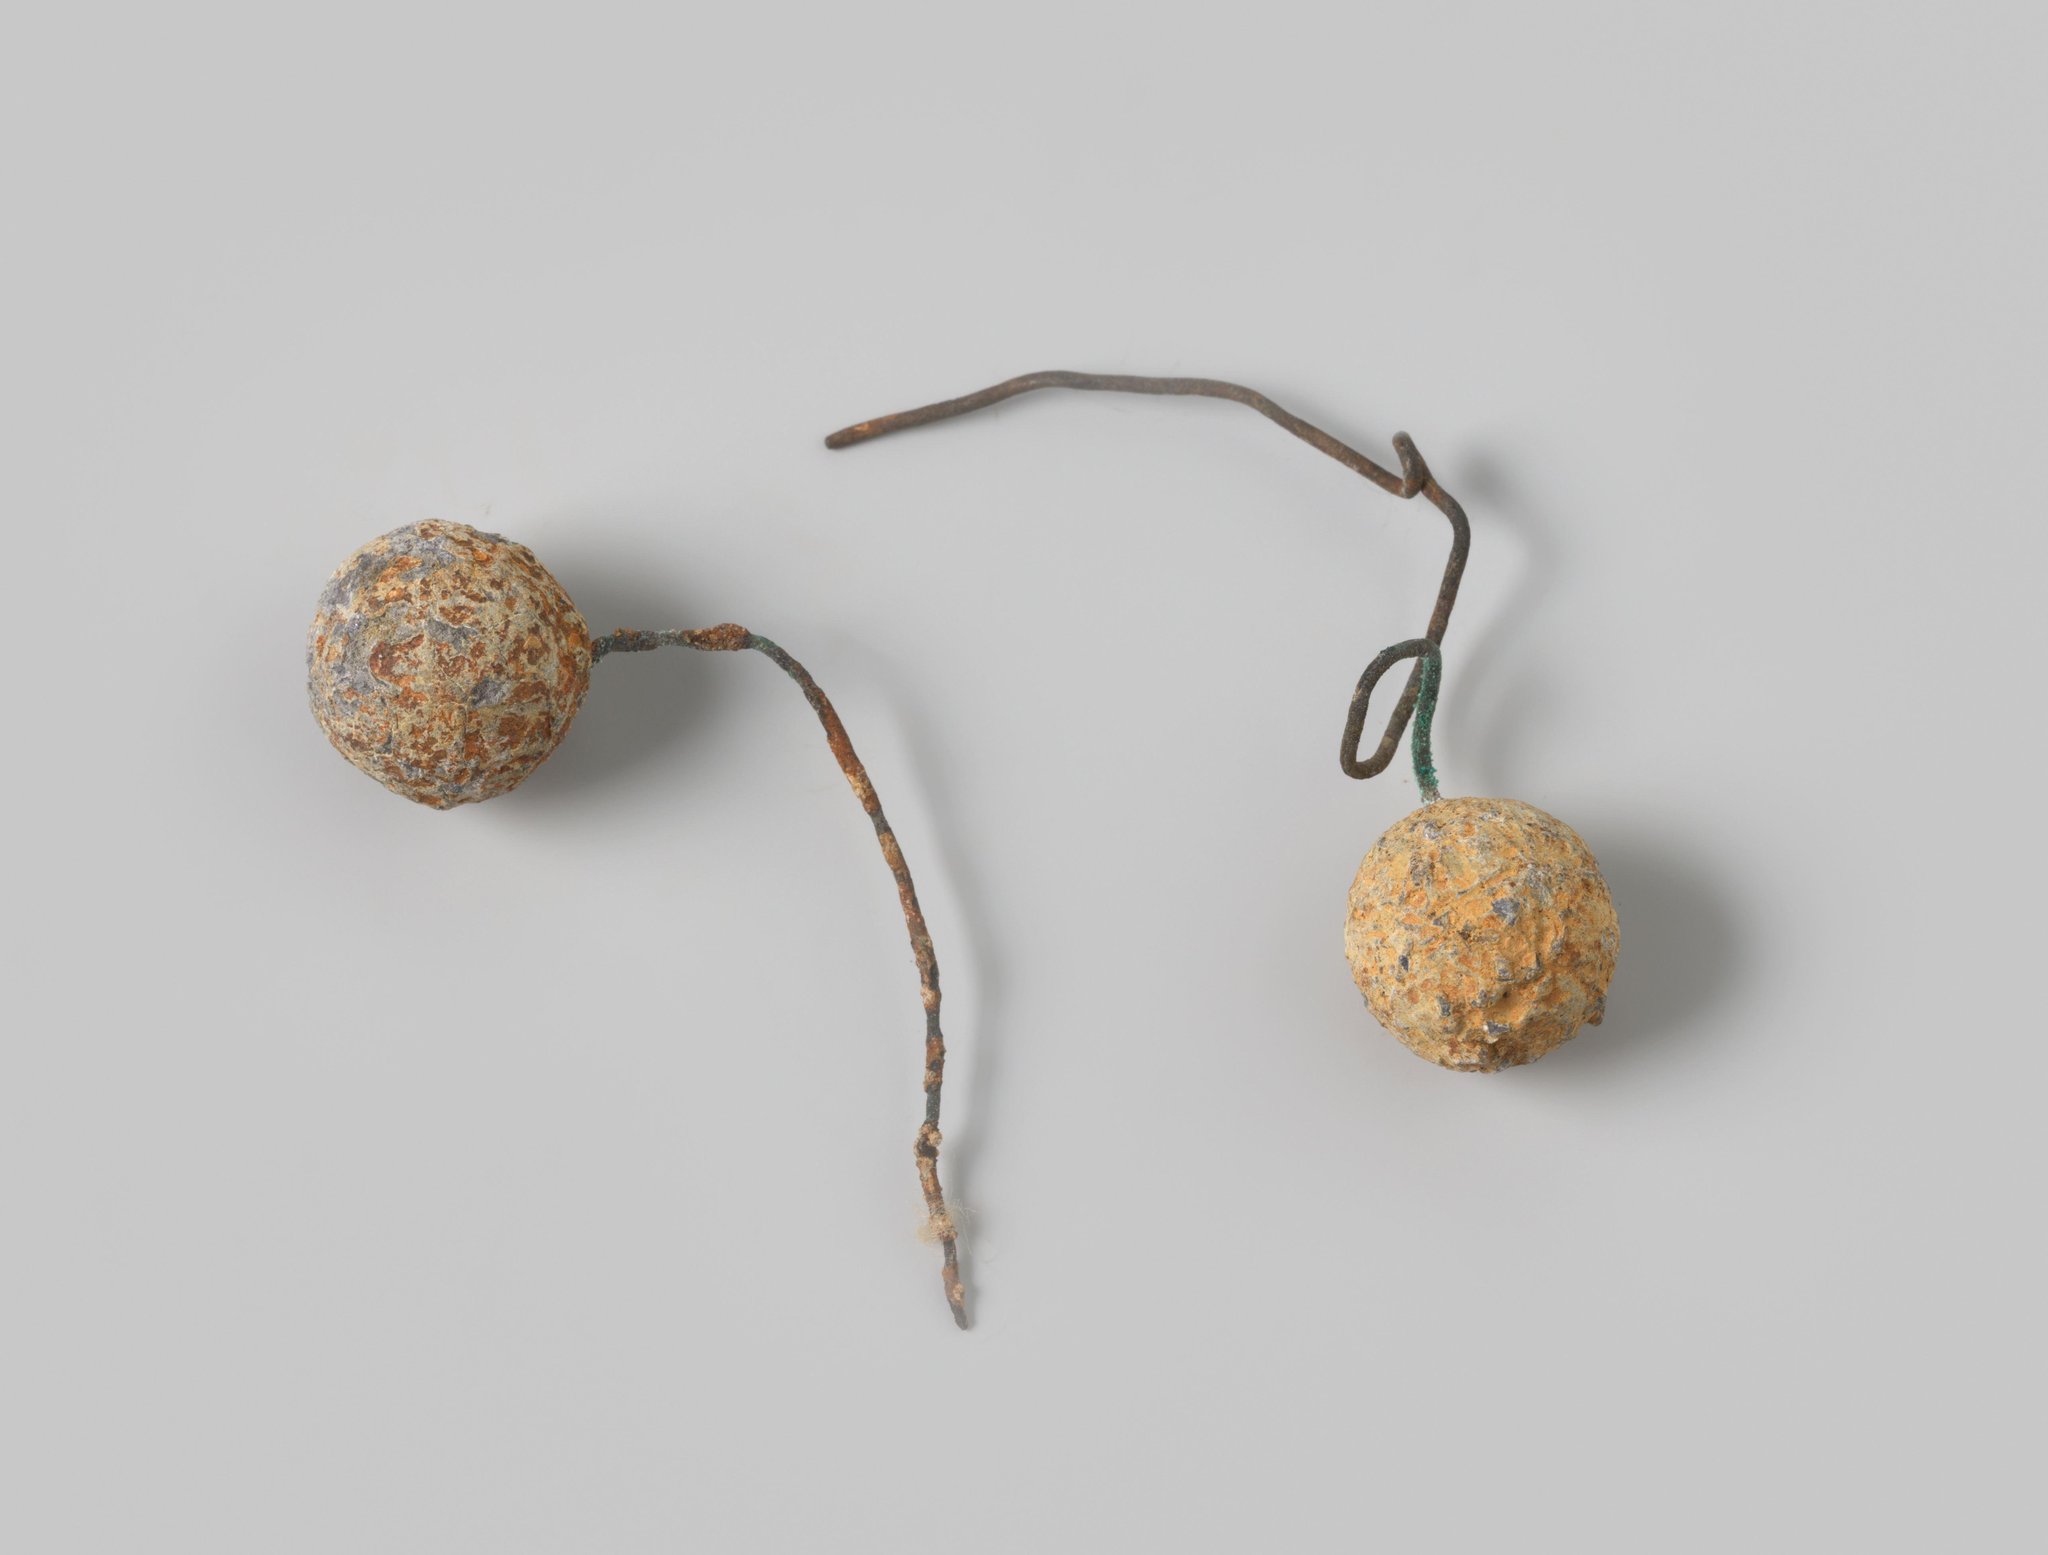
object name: chain shot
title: Kettingkogels uit het wrak van de Oost-Indiëvaarder Hollandia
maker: Anonymous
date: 1700-1743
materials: lead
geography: netherlands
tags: verenigde oostindische compagnie, hollandia (schip), annet